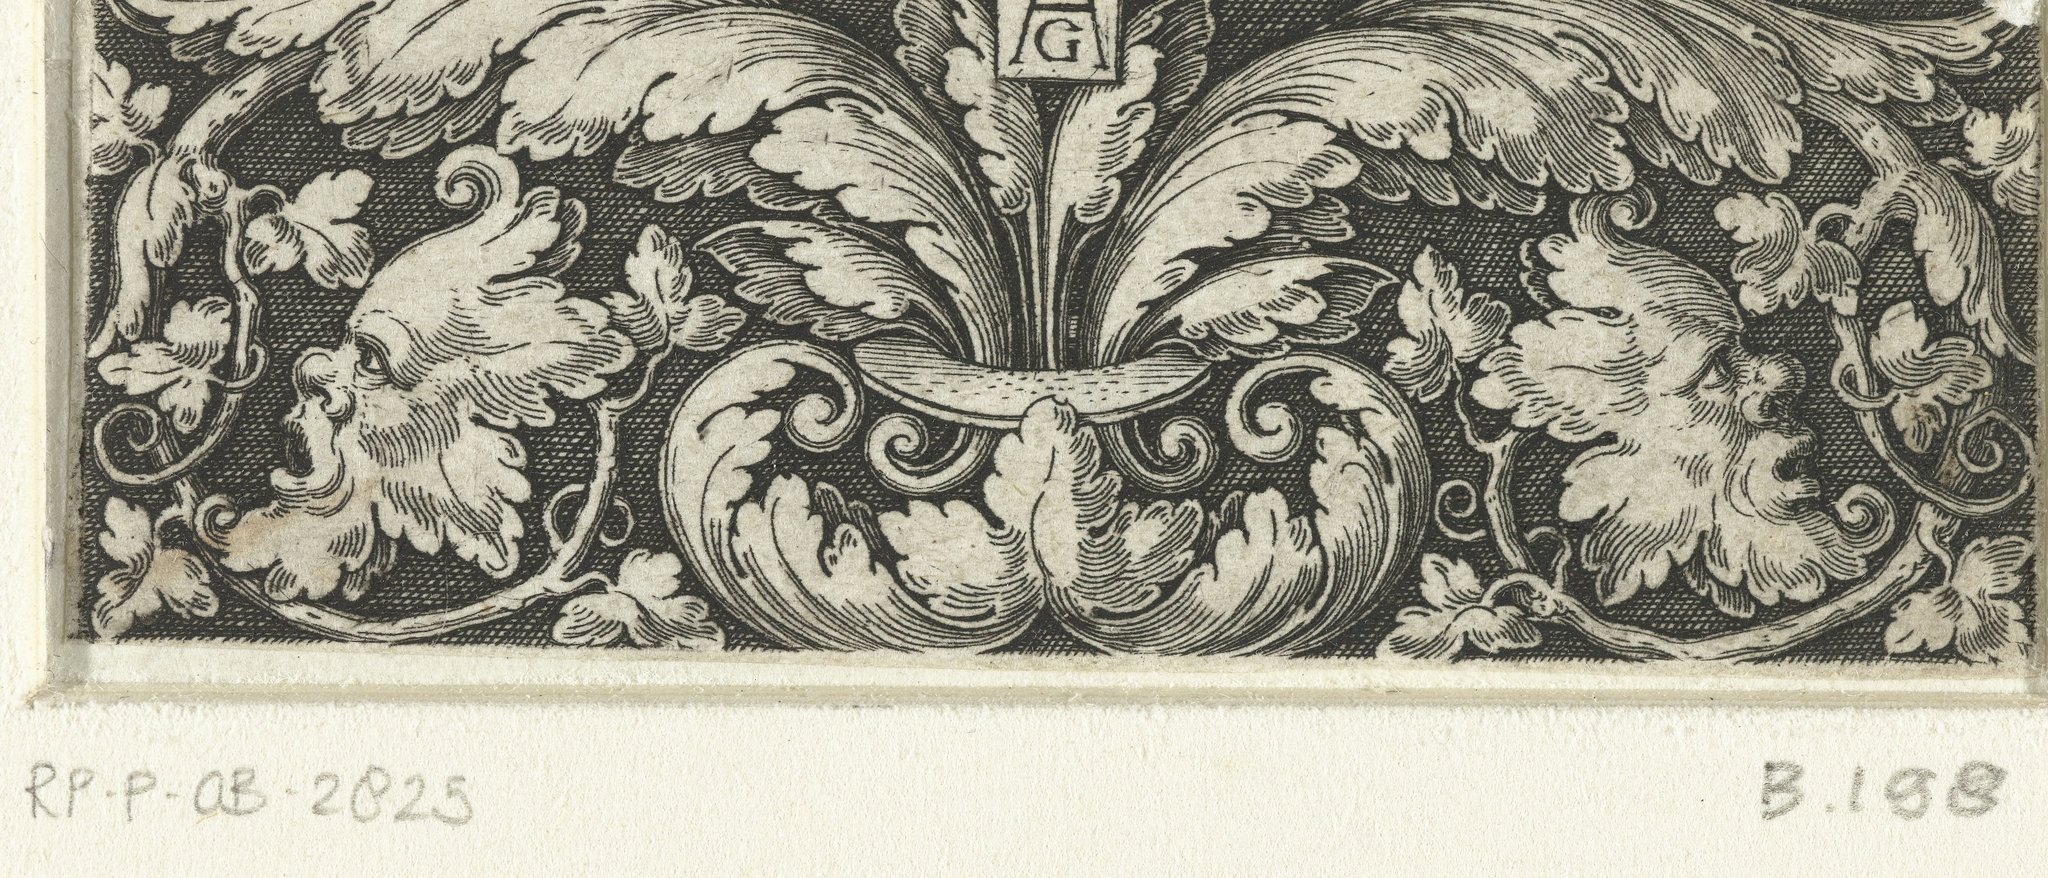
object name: print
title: Fries met bladranken en maskers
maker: heinrich aldegrever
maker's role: draughtsman, print maker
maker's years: 1502-1561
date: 1512-1560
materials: paper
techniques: engraving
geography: germany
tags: mask, mascaron ~ ornament, foliage, tendrils, branches ~ ornament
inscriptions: number: ‘12’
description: Ornament met bladranken die aan weerszijden uitlopen in een masker.